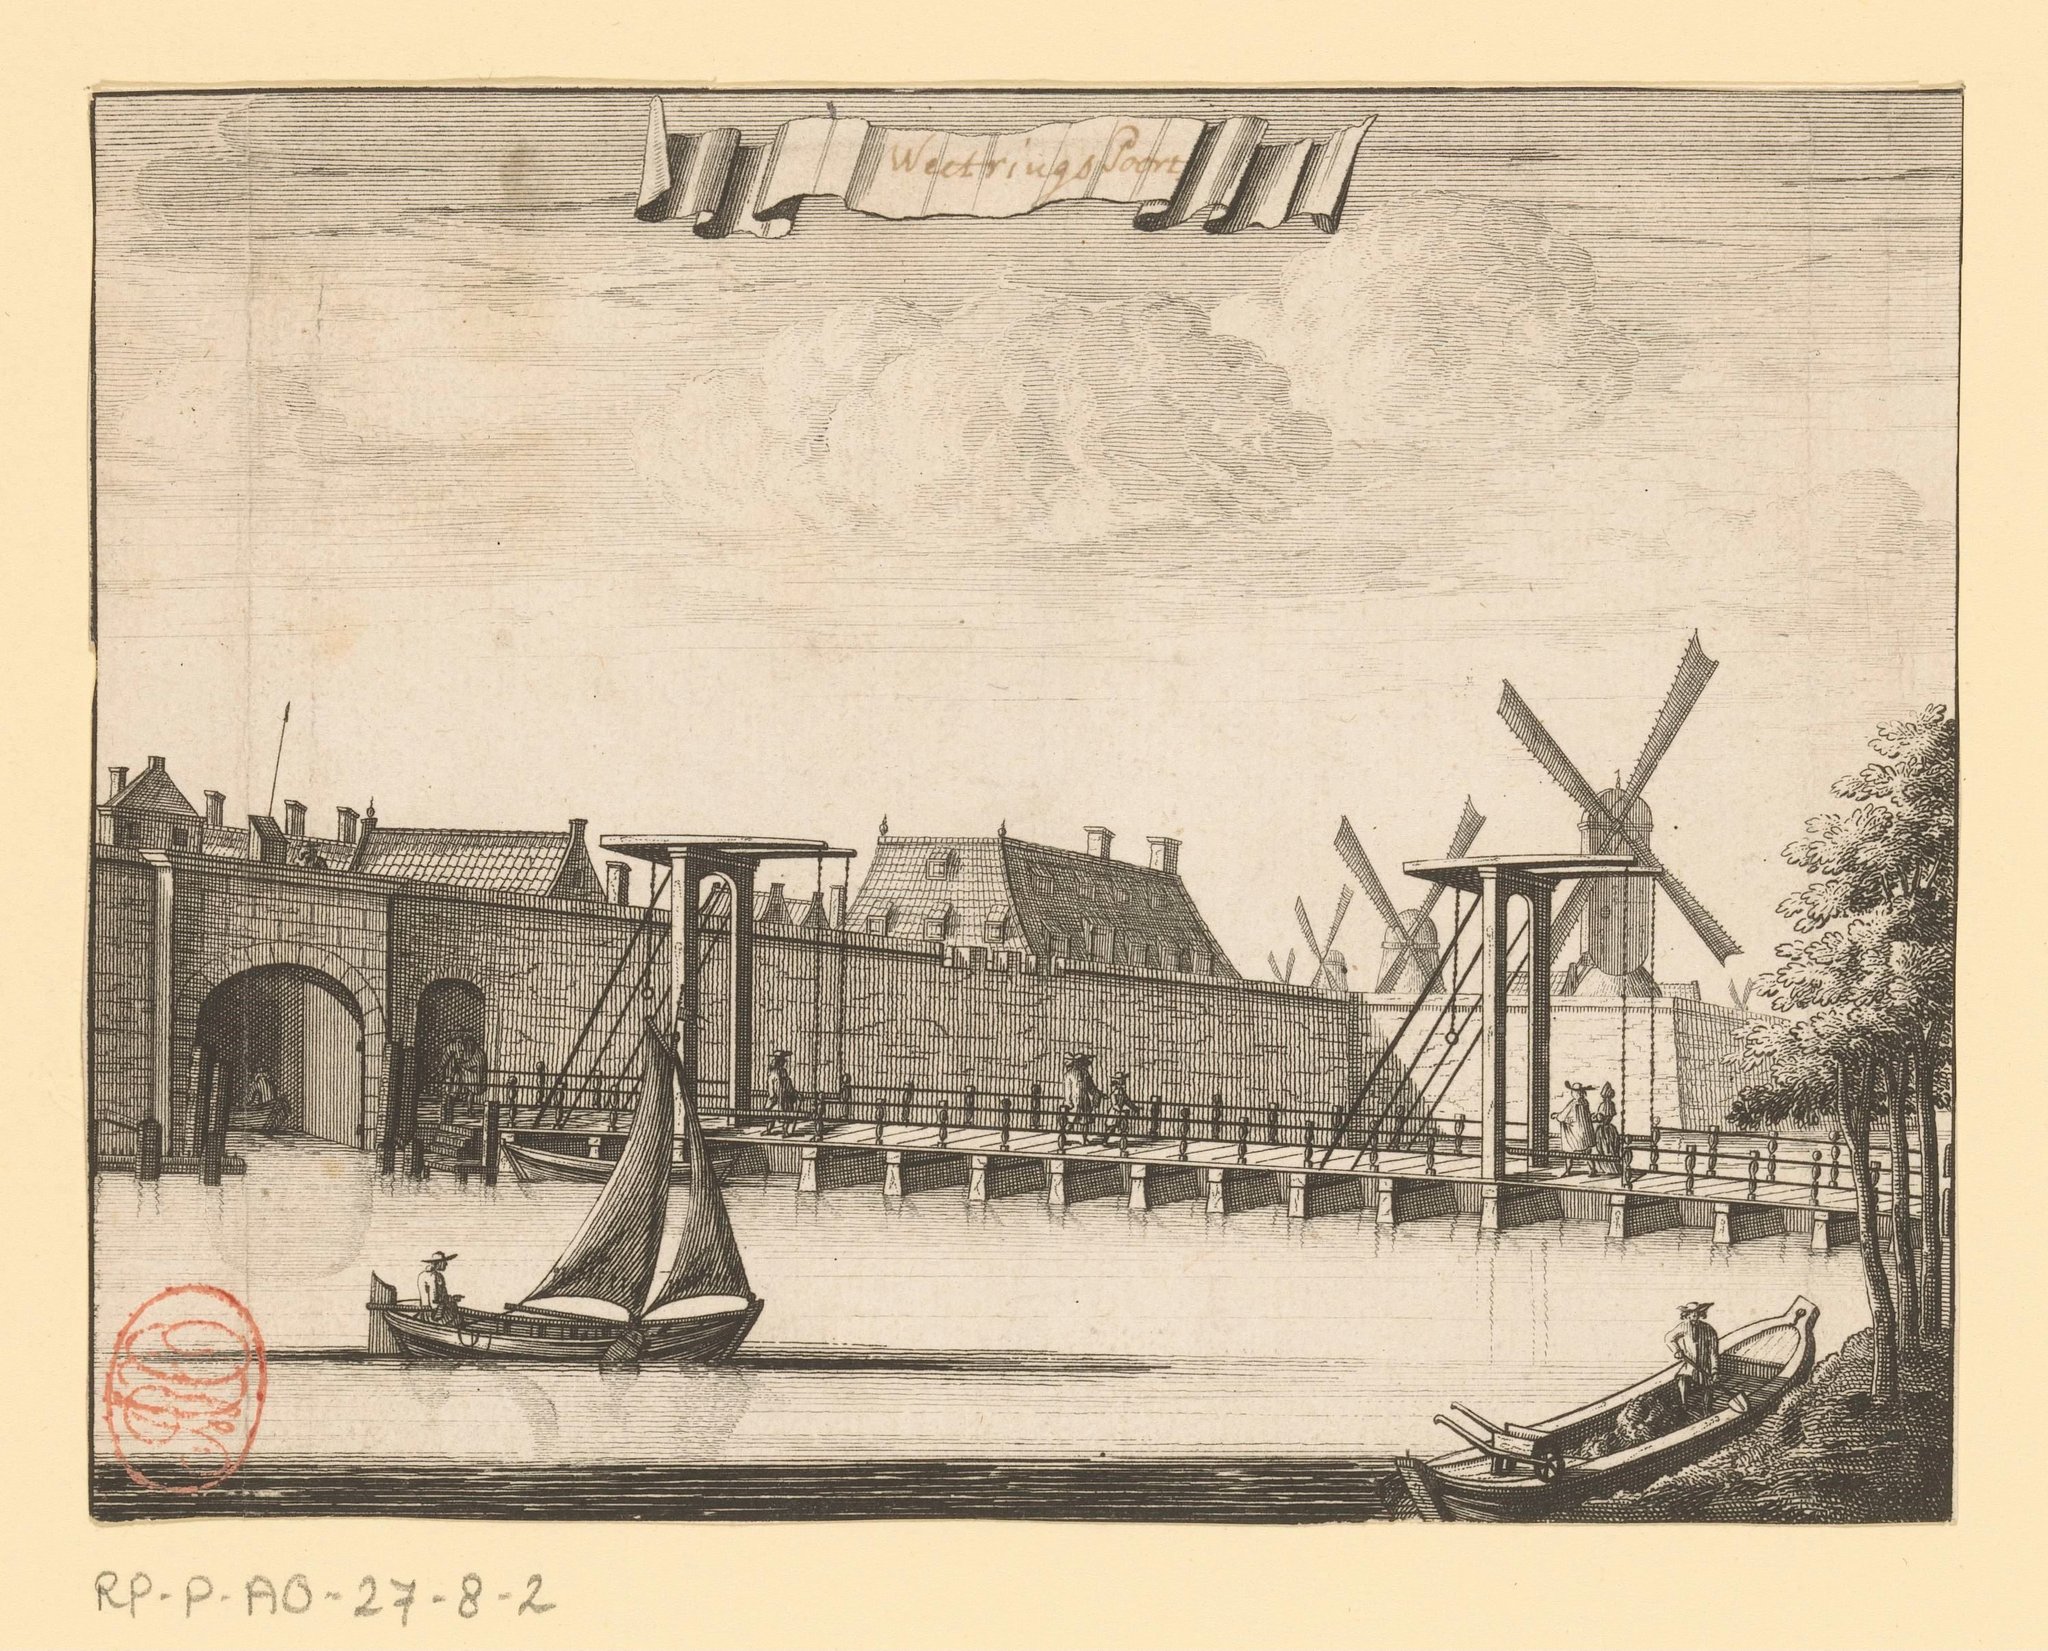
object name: print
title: Gezicht op de Weteringpoort te Amsterdam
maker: Anonymous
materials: paper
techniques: engraving, etching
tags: bridge, windmill, city-gate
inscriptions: inscription: ‘Weetrings Poort’, collector's mark: Lugt 195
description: Tweede bekende staat van prent ook gebruikt in: Commelin, Caspar. Beschryvinge van Amsterdam, desselfs eerste oorspronk uyt den Huyse (…). 2 delen. Amsterdam: Abraham Wolfgang, Gillis Janssonius van Waesberge, Johannes Janssonius van Waesberge II, weduwe Dirk Boom I, Hendrick Boom en Rembertus Goethals, 1693. En in: Commelin, Caspar. Beschryvinge van Amsterdam, zynde een naukeurige verhandelinge van desselfs eerste oorspronk uyt (…). 2 delen. Amsterdam: weduwe Aart Dircksz Oossaan, 1694. Derde bekende staat ook gebruikt in: Commelin, Caspar. Beschryvinge van Amsterdam, zynde een naukeurige verhandelinge van desselfs eerste oorspronk uyt (…). 2 delen. 2e druk. Amsterdam: Andries van Damme, Johannes Ratelband, weduwe A. van Aaltwyk en Hermanus Uytwerf, 1726. Zie RP-P-AO-27-8-3 voor tweede bekende staat. Zie RP-P-2017-10361 voor derde bekende staat.